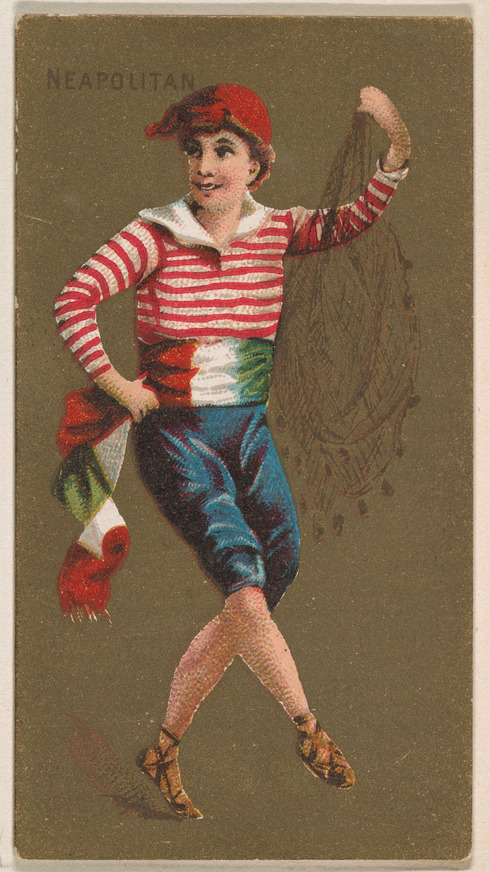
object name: print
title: Neapolitan, from National Dances (N225, Type 2) issued by Kinney Bros.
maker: kinney brothers tobacco company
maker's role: publisher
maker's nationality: american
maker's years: 1869-2011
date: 1889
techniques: color lithograph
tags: men,dancers